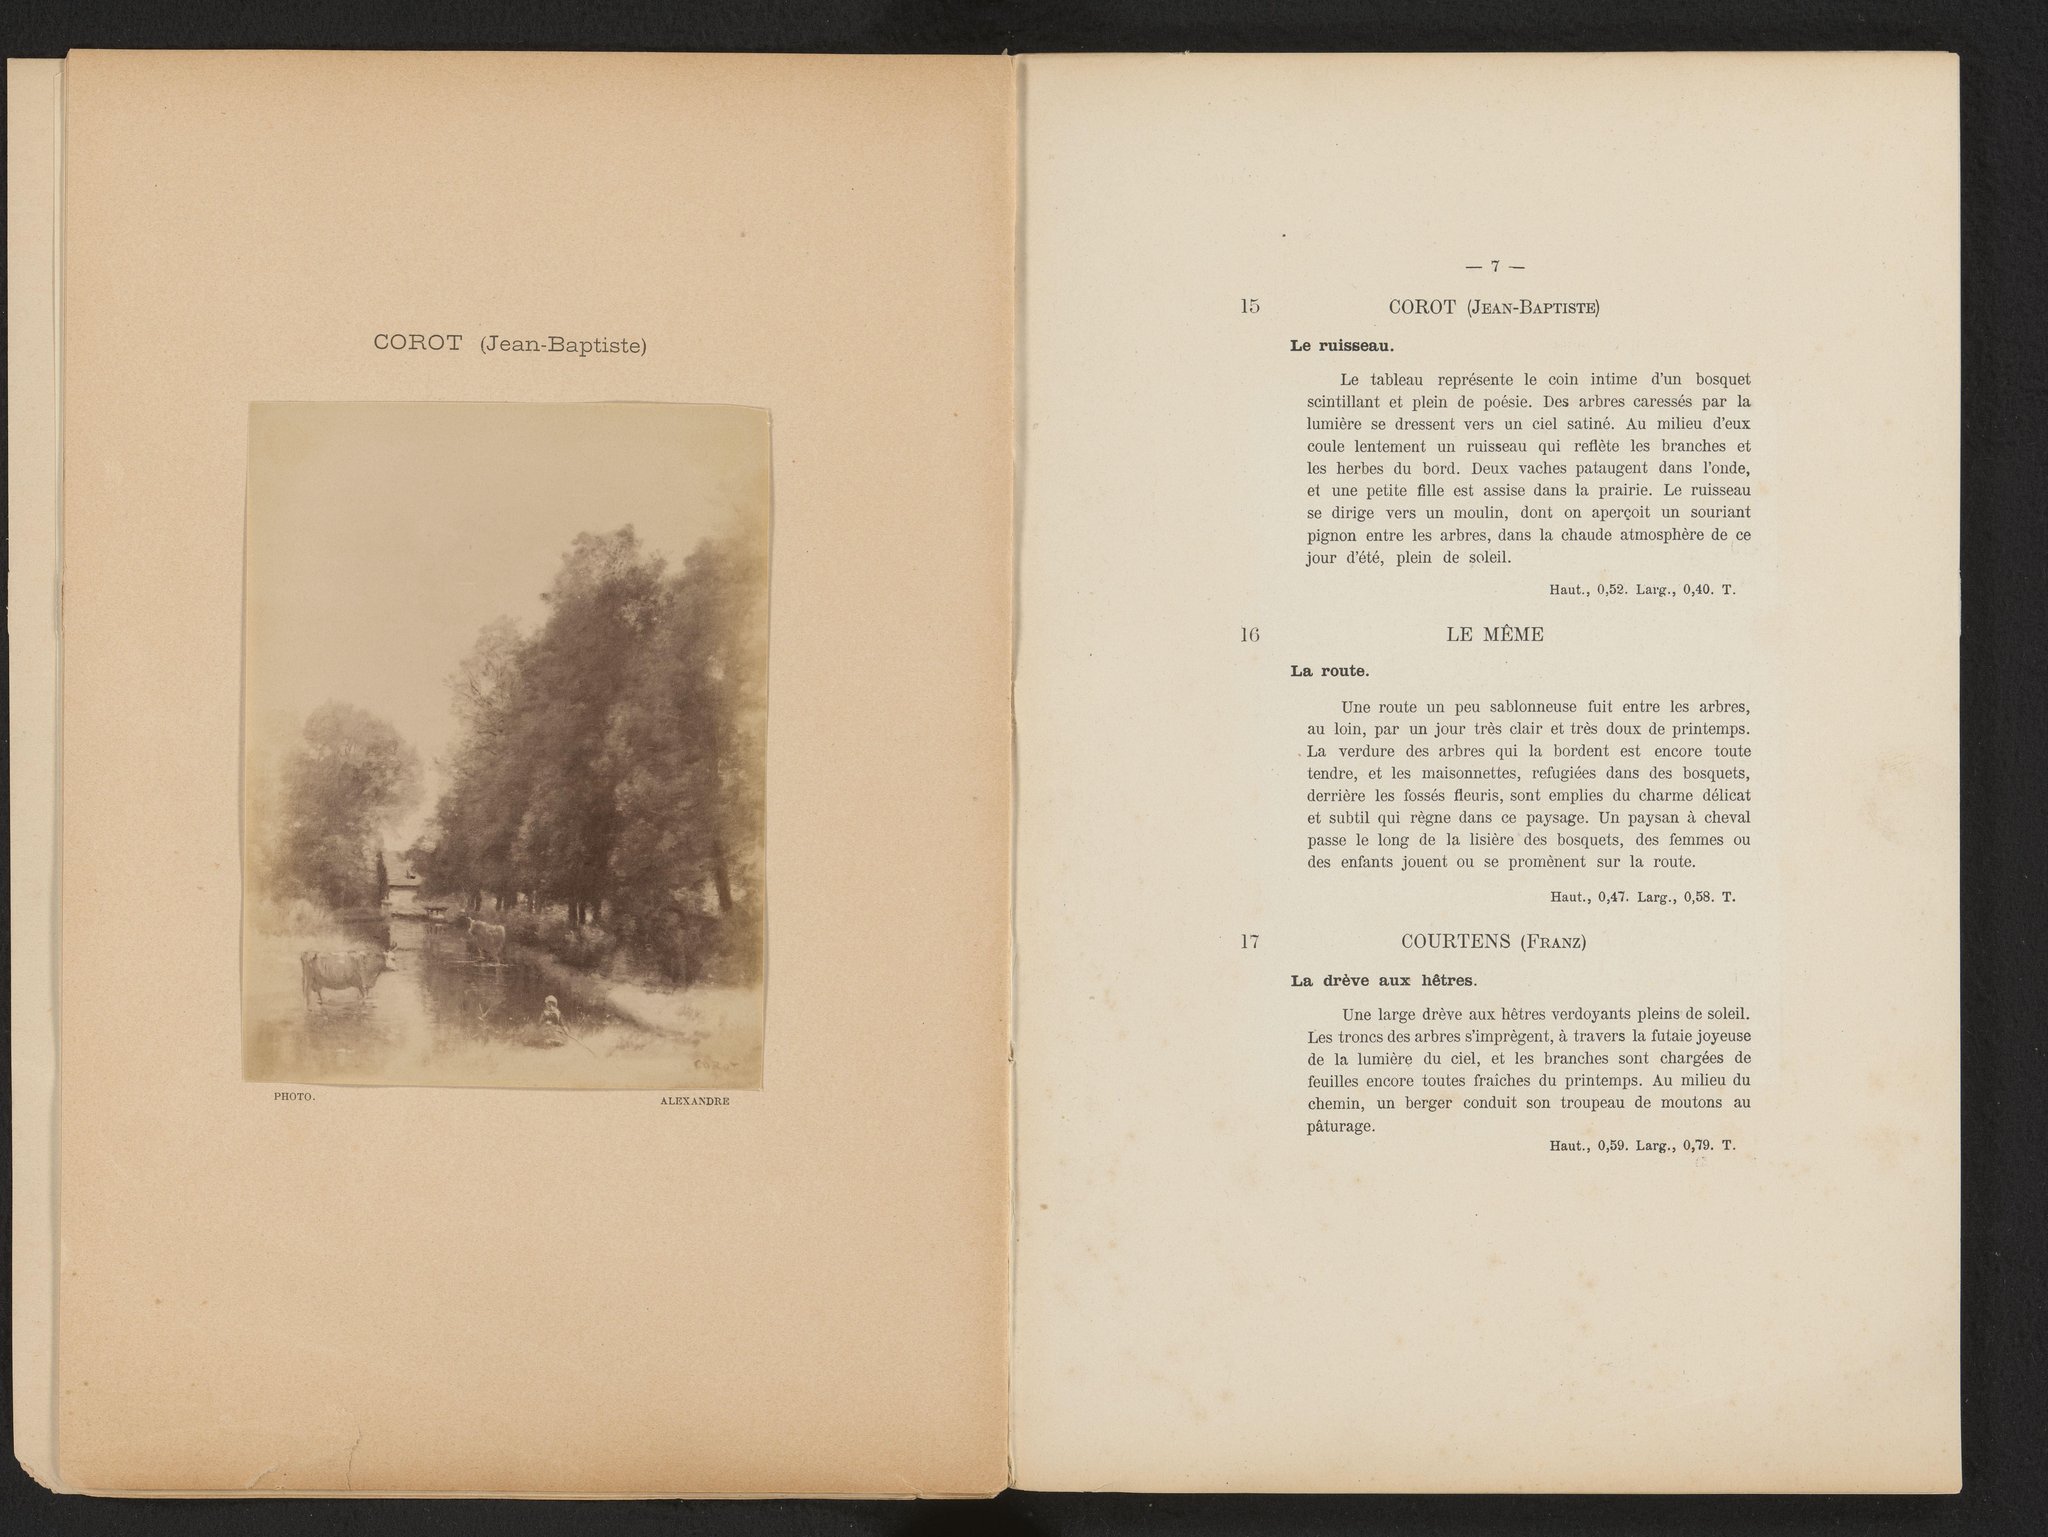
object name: reproduction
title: Fotoreproductie van Le ruisseau door Jean-Baptiste Camille Corot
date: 1888-1893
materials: photographic support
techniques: albumen print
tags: cow, landscapes with waters, waterscapes, seascapes (in the temperate zone), painting, drawing and the graphic arts